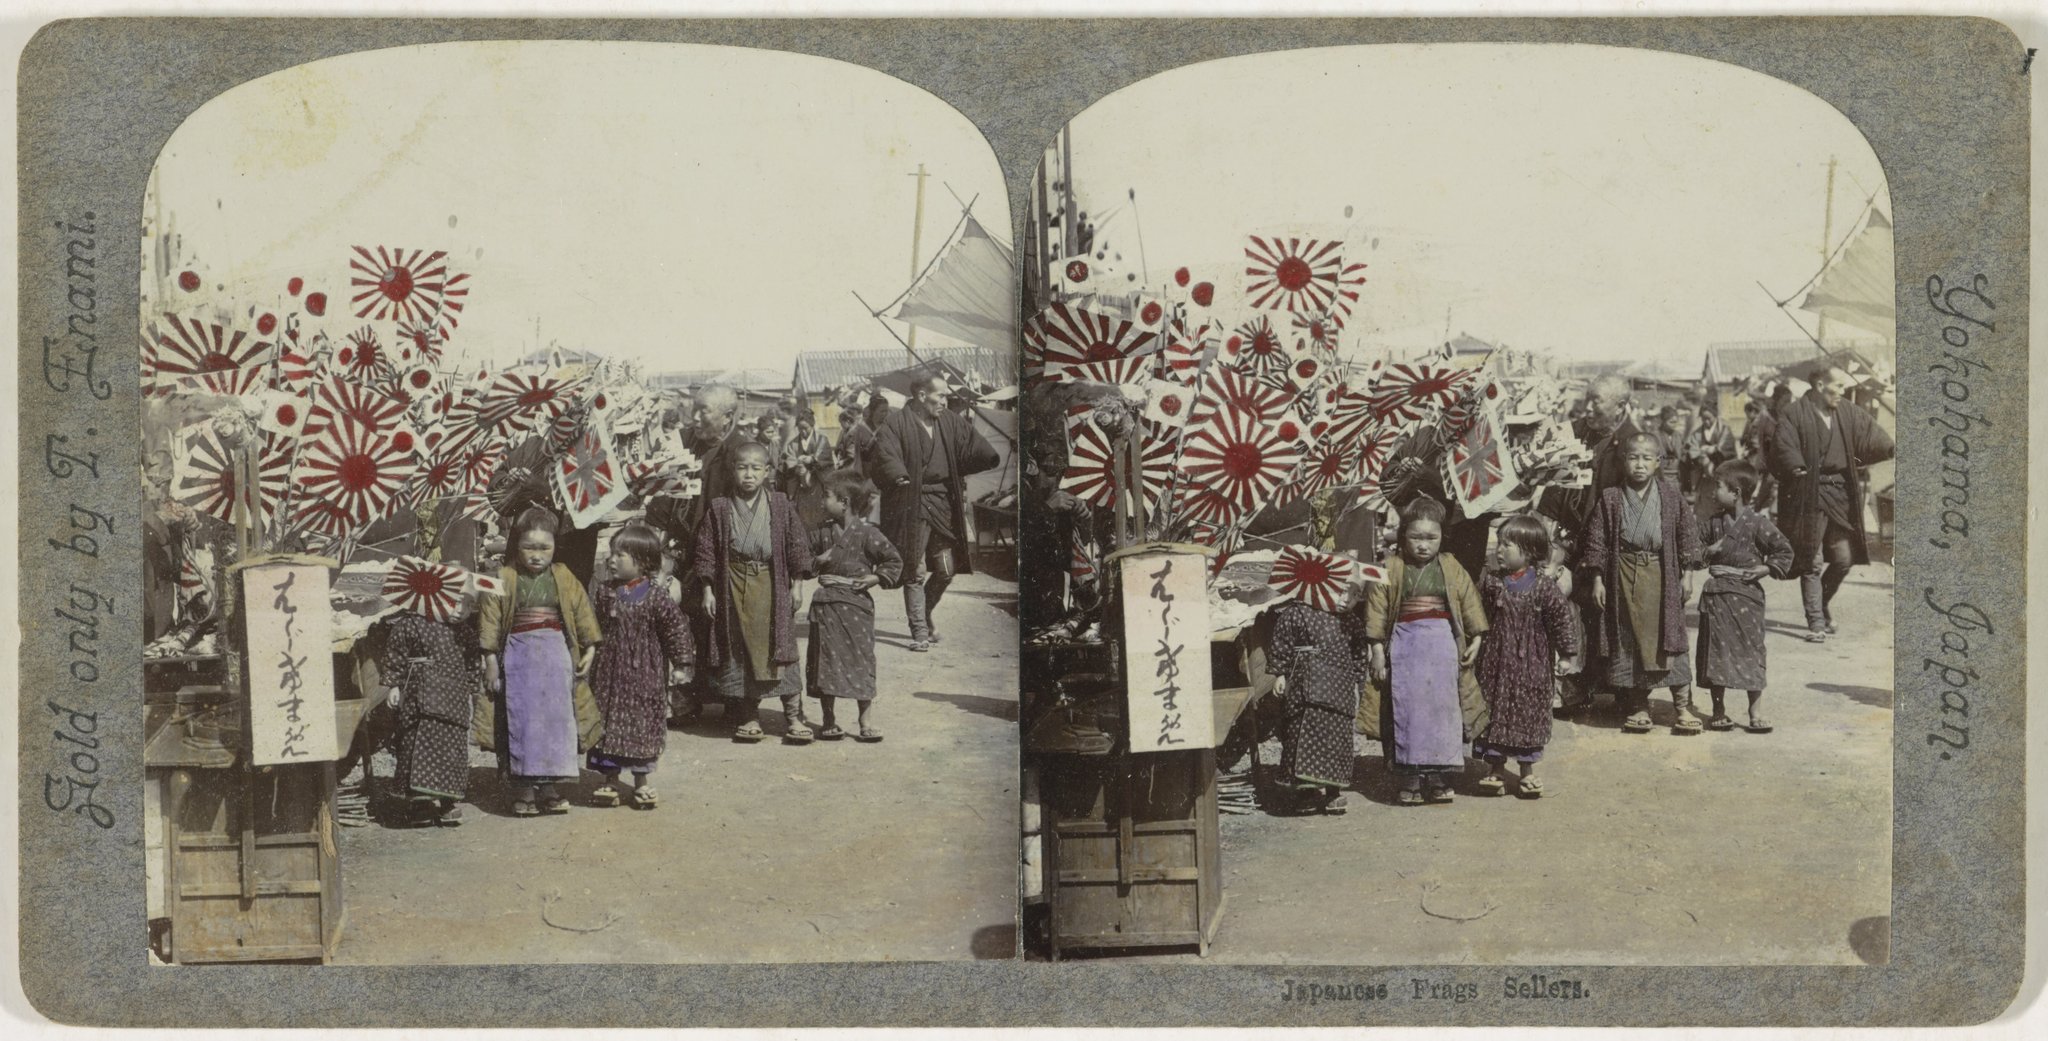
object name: stereograph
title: Japanese Frags Sellers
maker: t. enami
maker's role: publisher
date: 1900-1907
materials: paper, cardboard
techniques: hand coloring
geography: japan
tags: flag, colours (as symbol of the state, etc.), japan